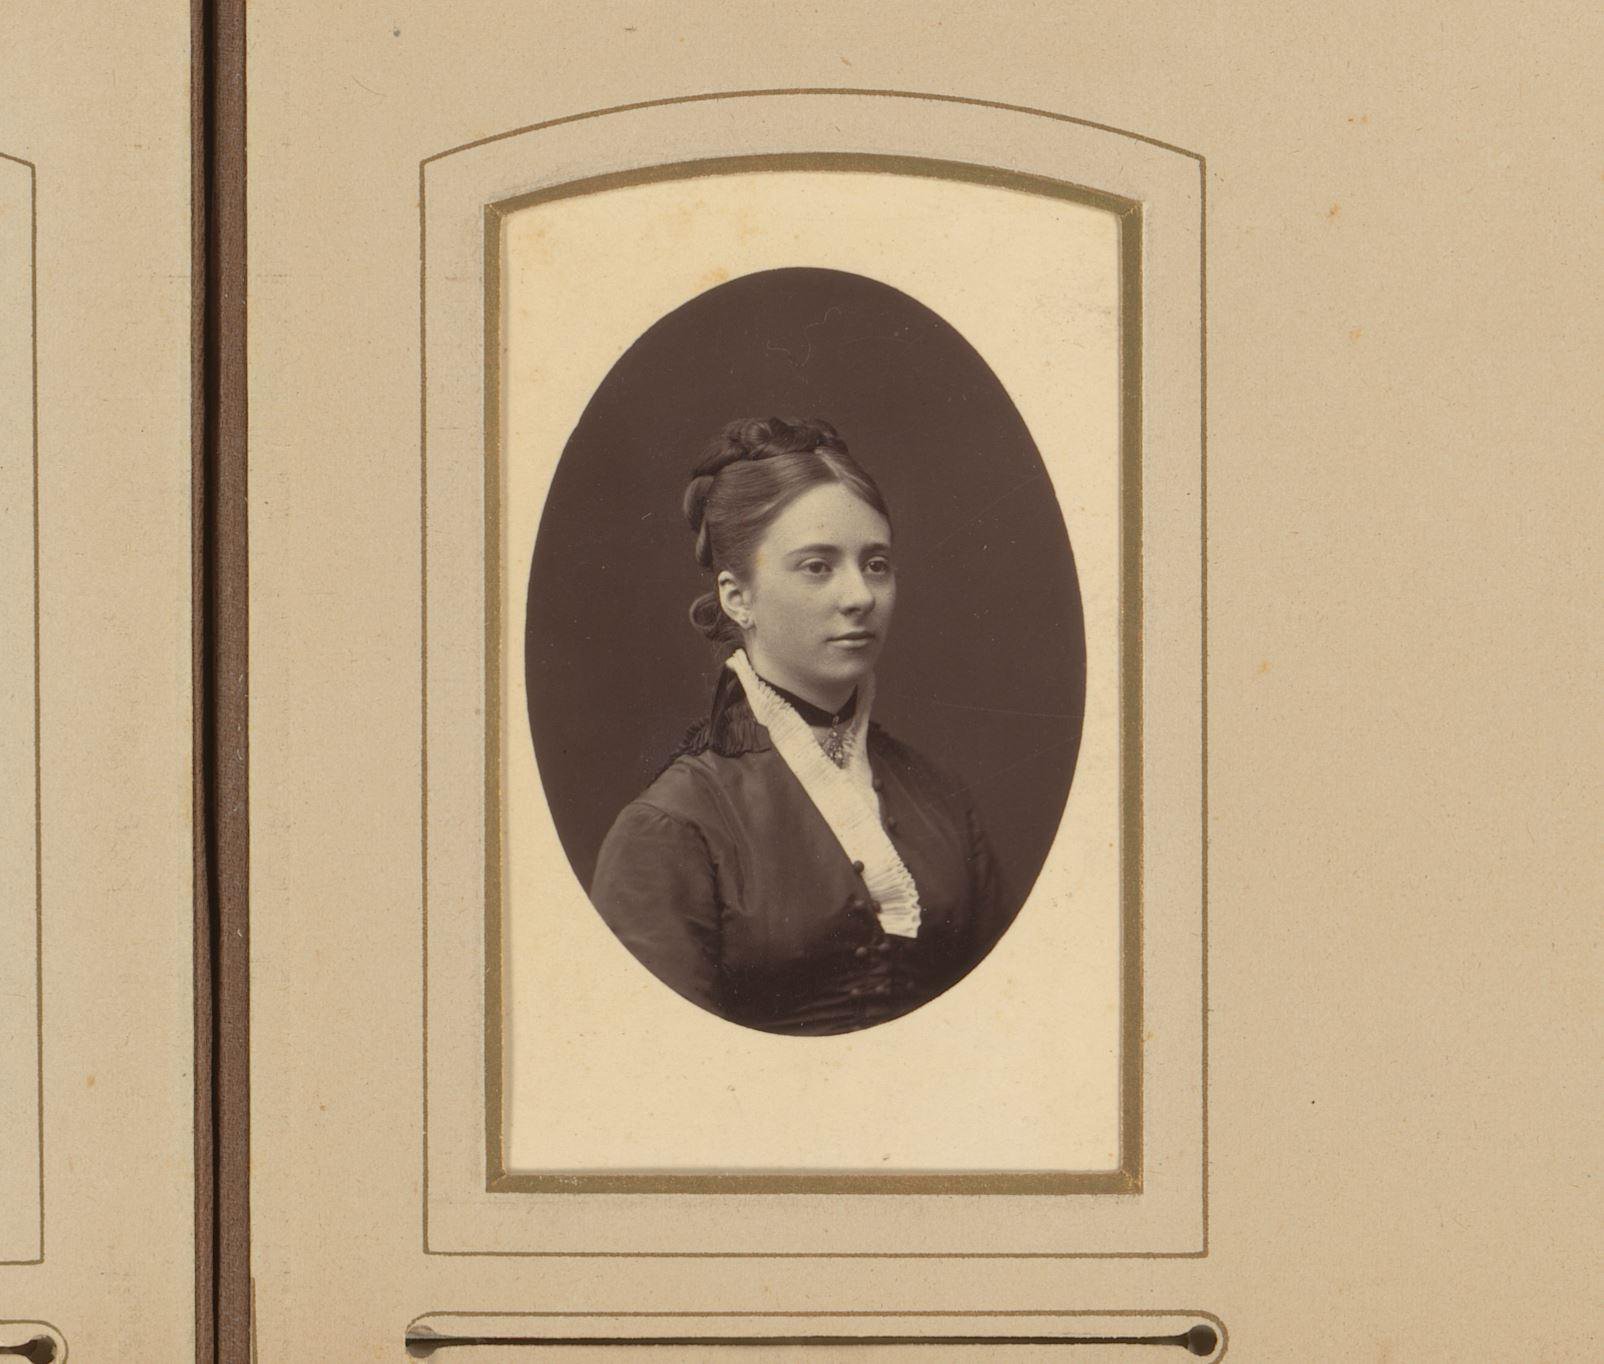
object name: photograph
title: Portret van een jonge vrouw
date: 1866-1890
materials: cardboard, photographic support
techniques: albumen print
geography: brussels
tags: adolescent, young woman, maiden, historical persons - bb - woman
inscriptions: inscription: ‘(...)/ Géruzet Frères/ Photographes de S.M. la Reine des Belges/ 27b Rue de l'Ecuyer/ Bruxelles/ Les Clichés sont conservés.’